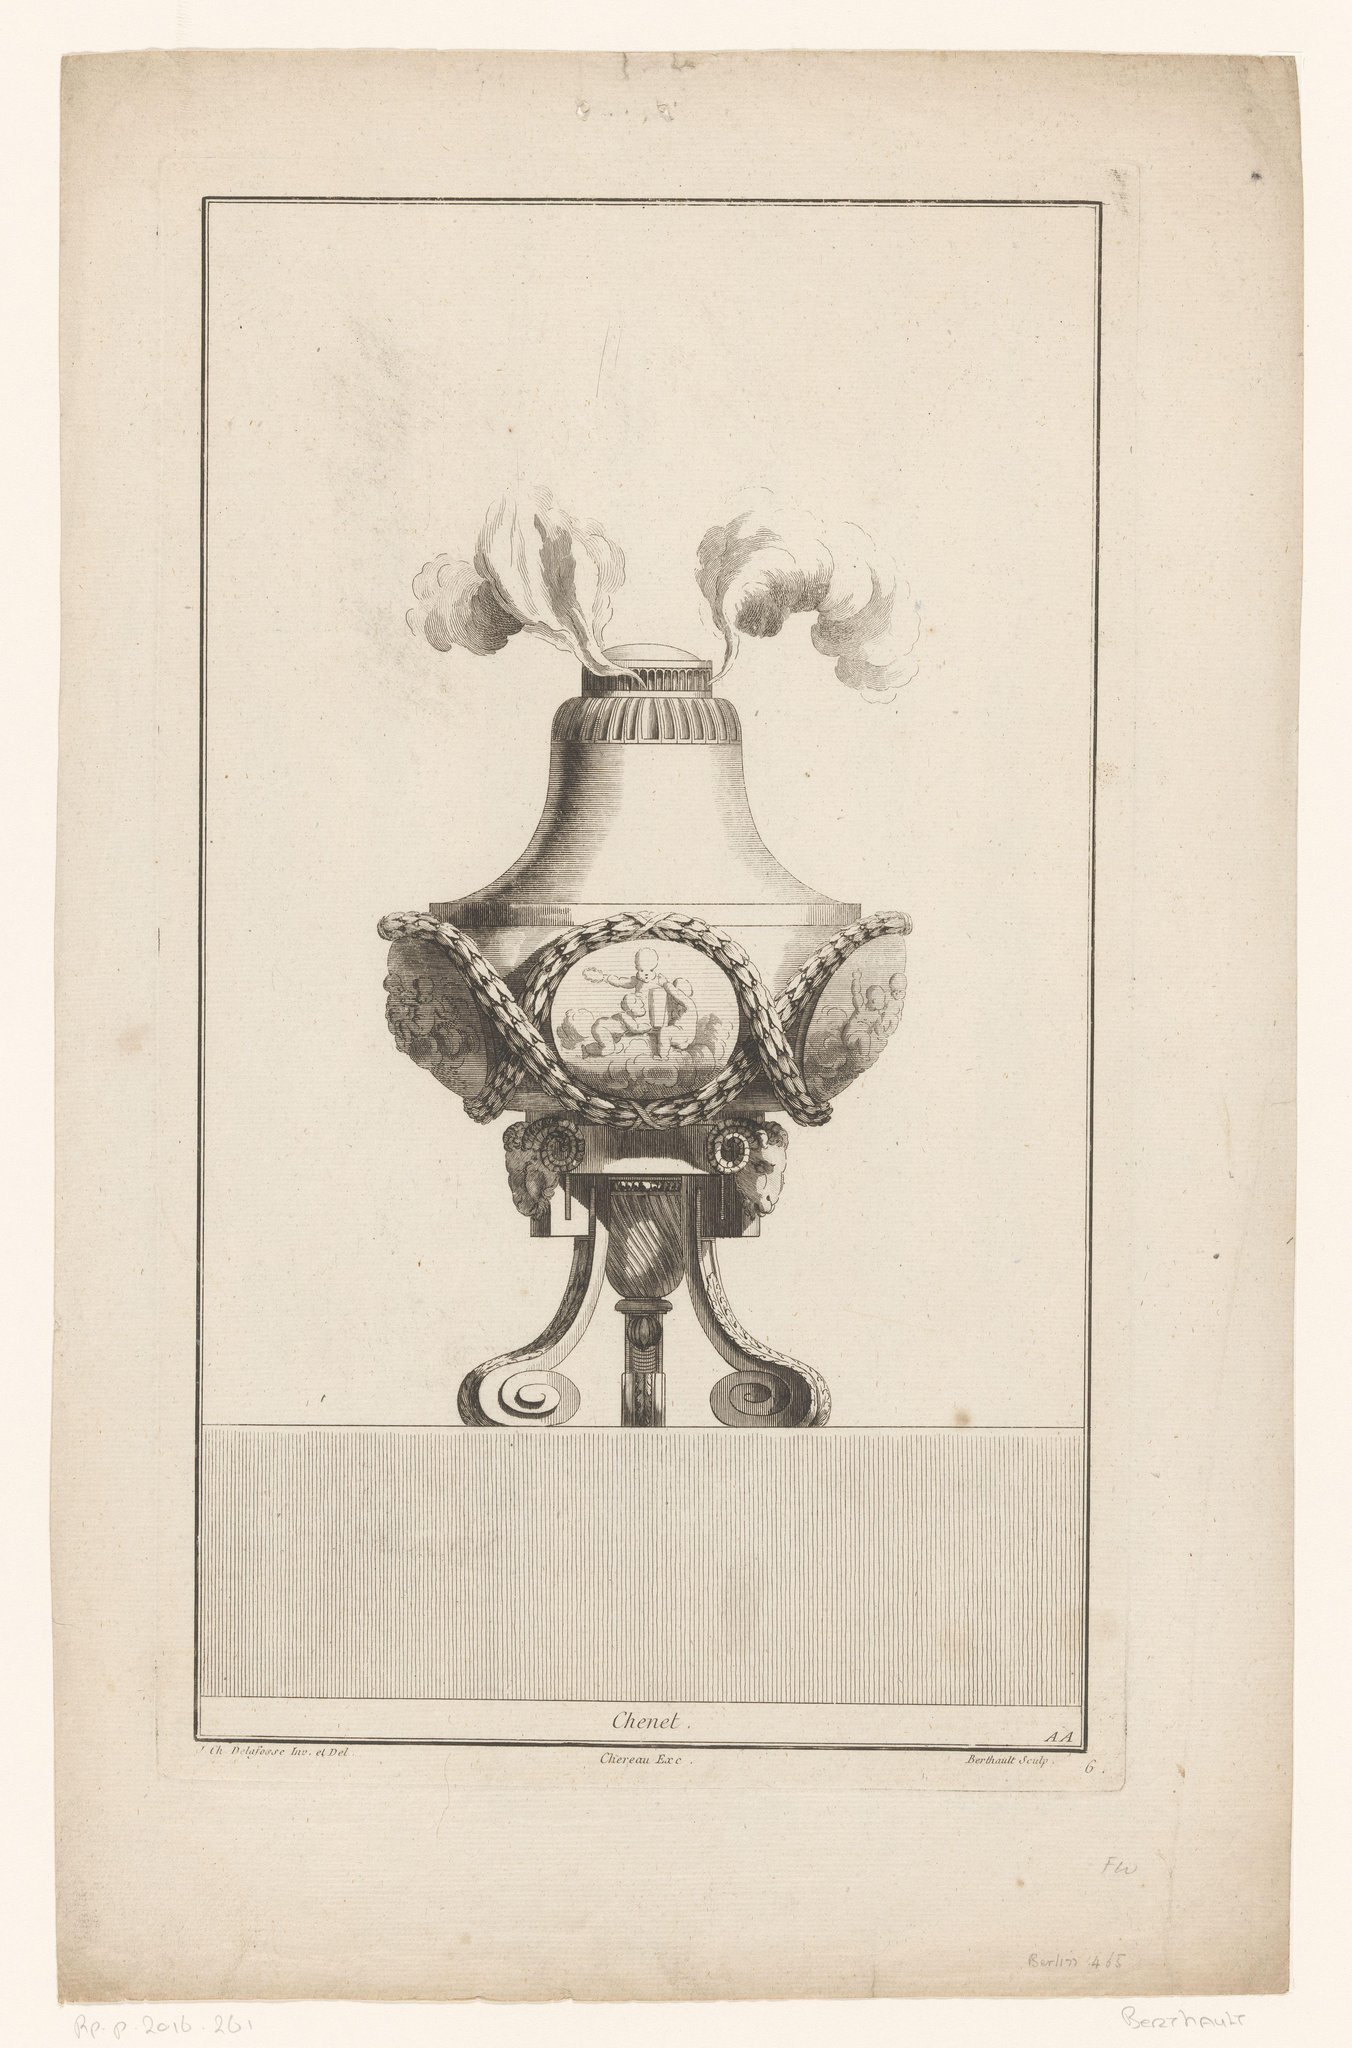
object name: ornament print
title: IIe Volume De l'Oeuvre de J. Ch. Delafosse (...)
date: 1771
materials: paper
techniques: engraving, etching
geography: paris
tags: andiron, fire-dog, incense-burner ~ scents, perfumes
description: Een geornamenteerde vuurbok in de vorm van een rookvat met medaillons met putti en ramskoppen.